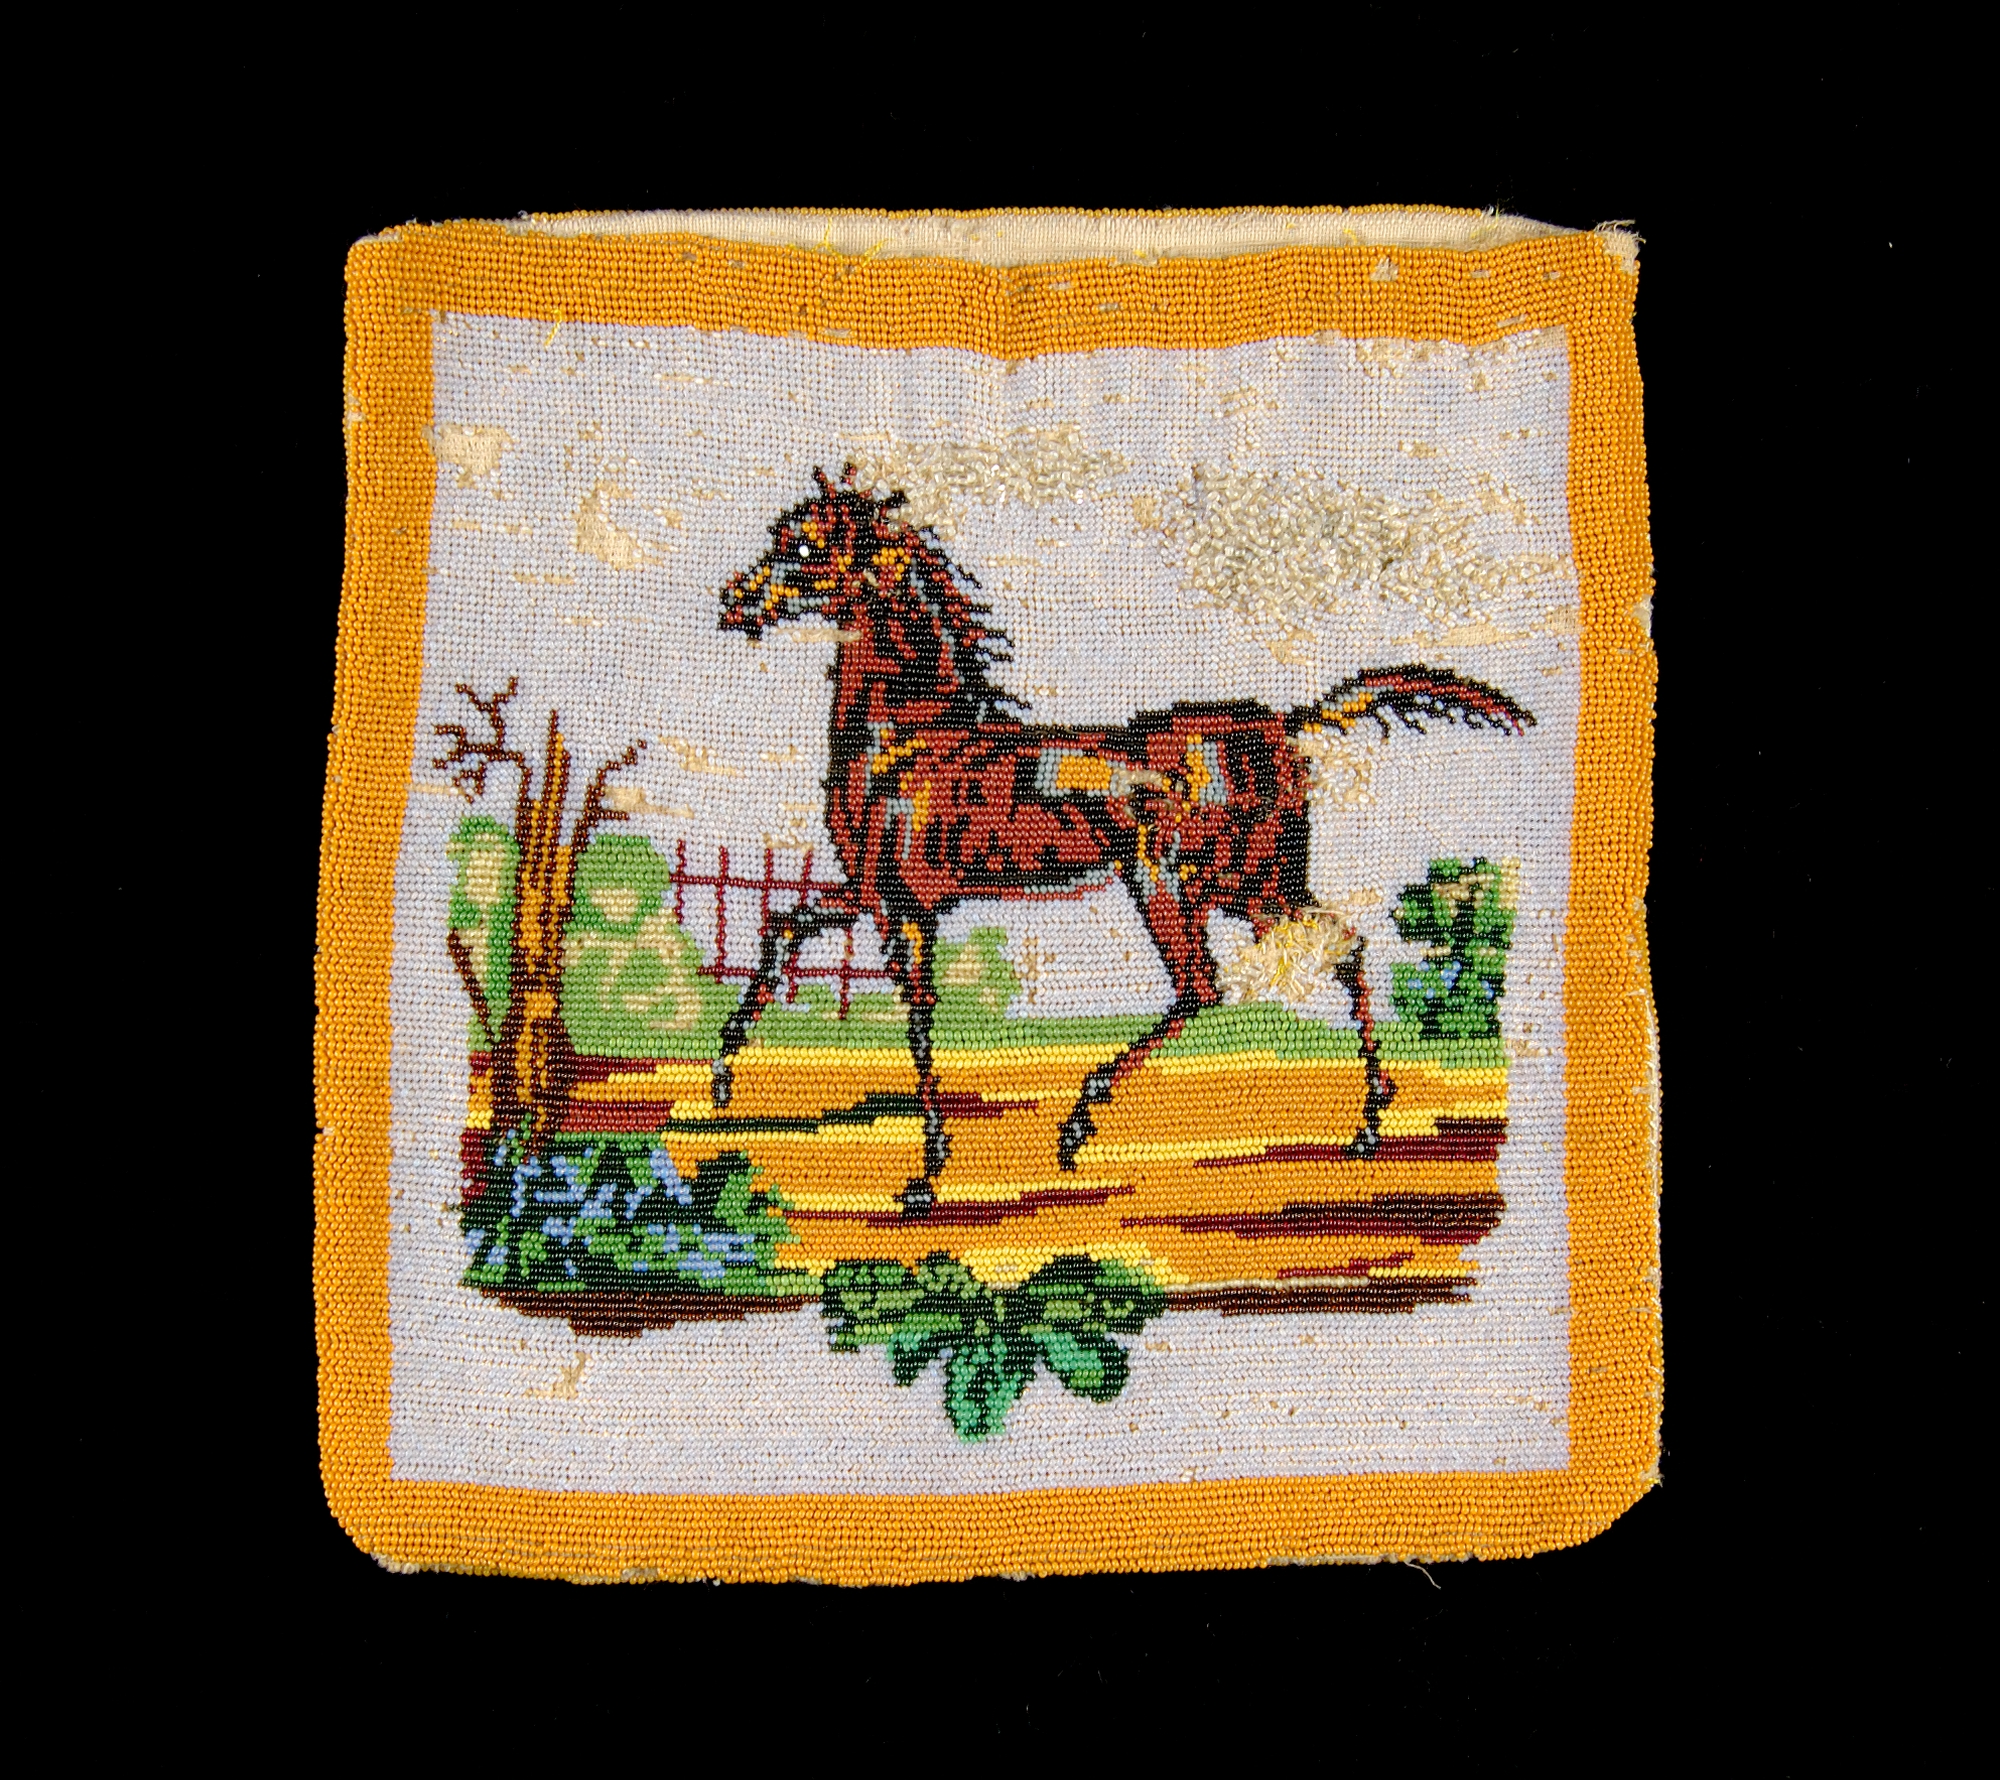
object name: bag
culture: italian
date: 1830-1860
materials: glass, linen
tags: horses